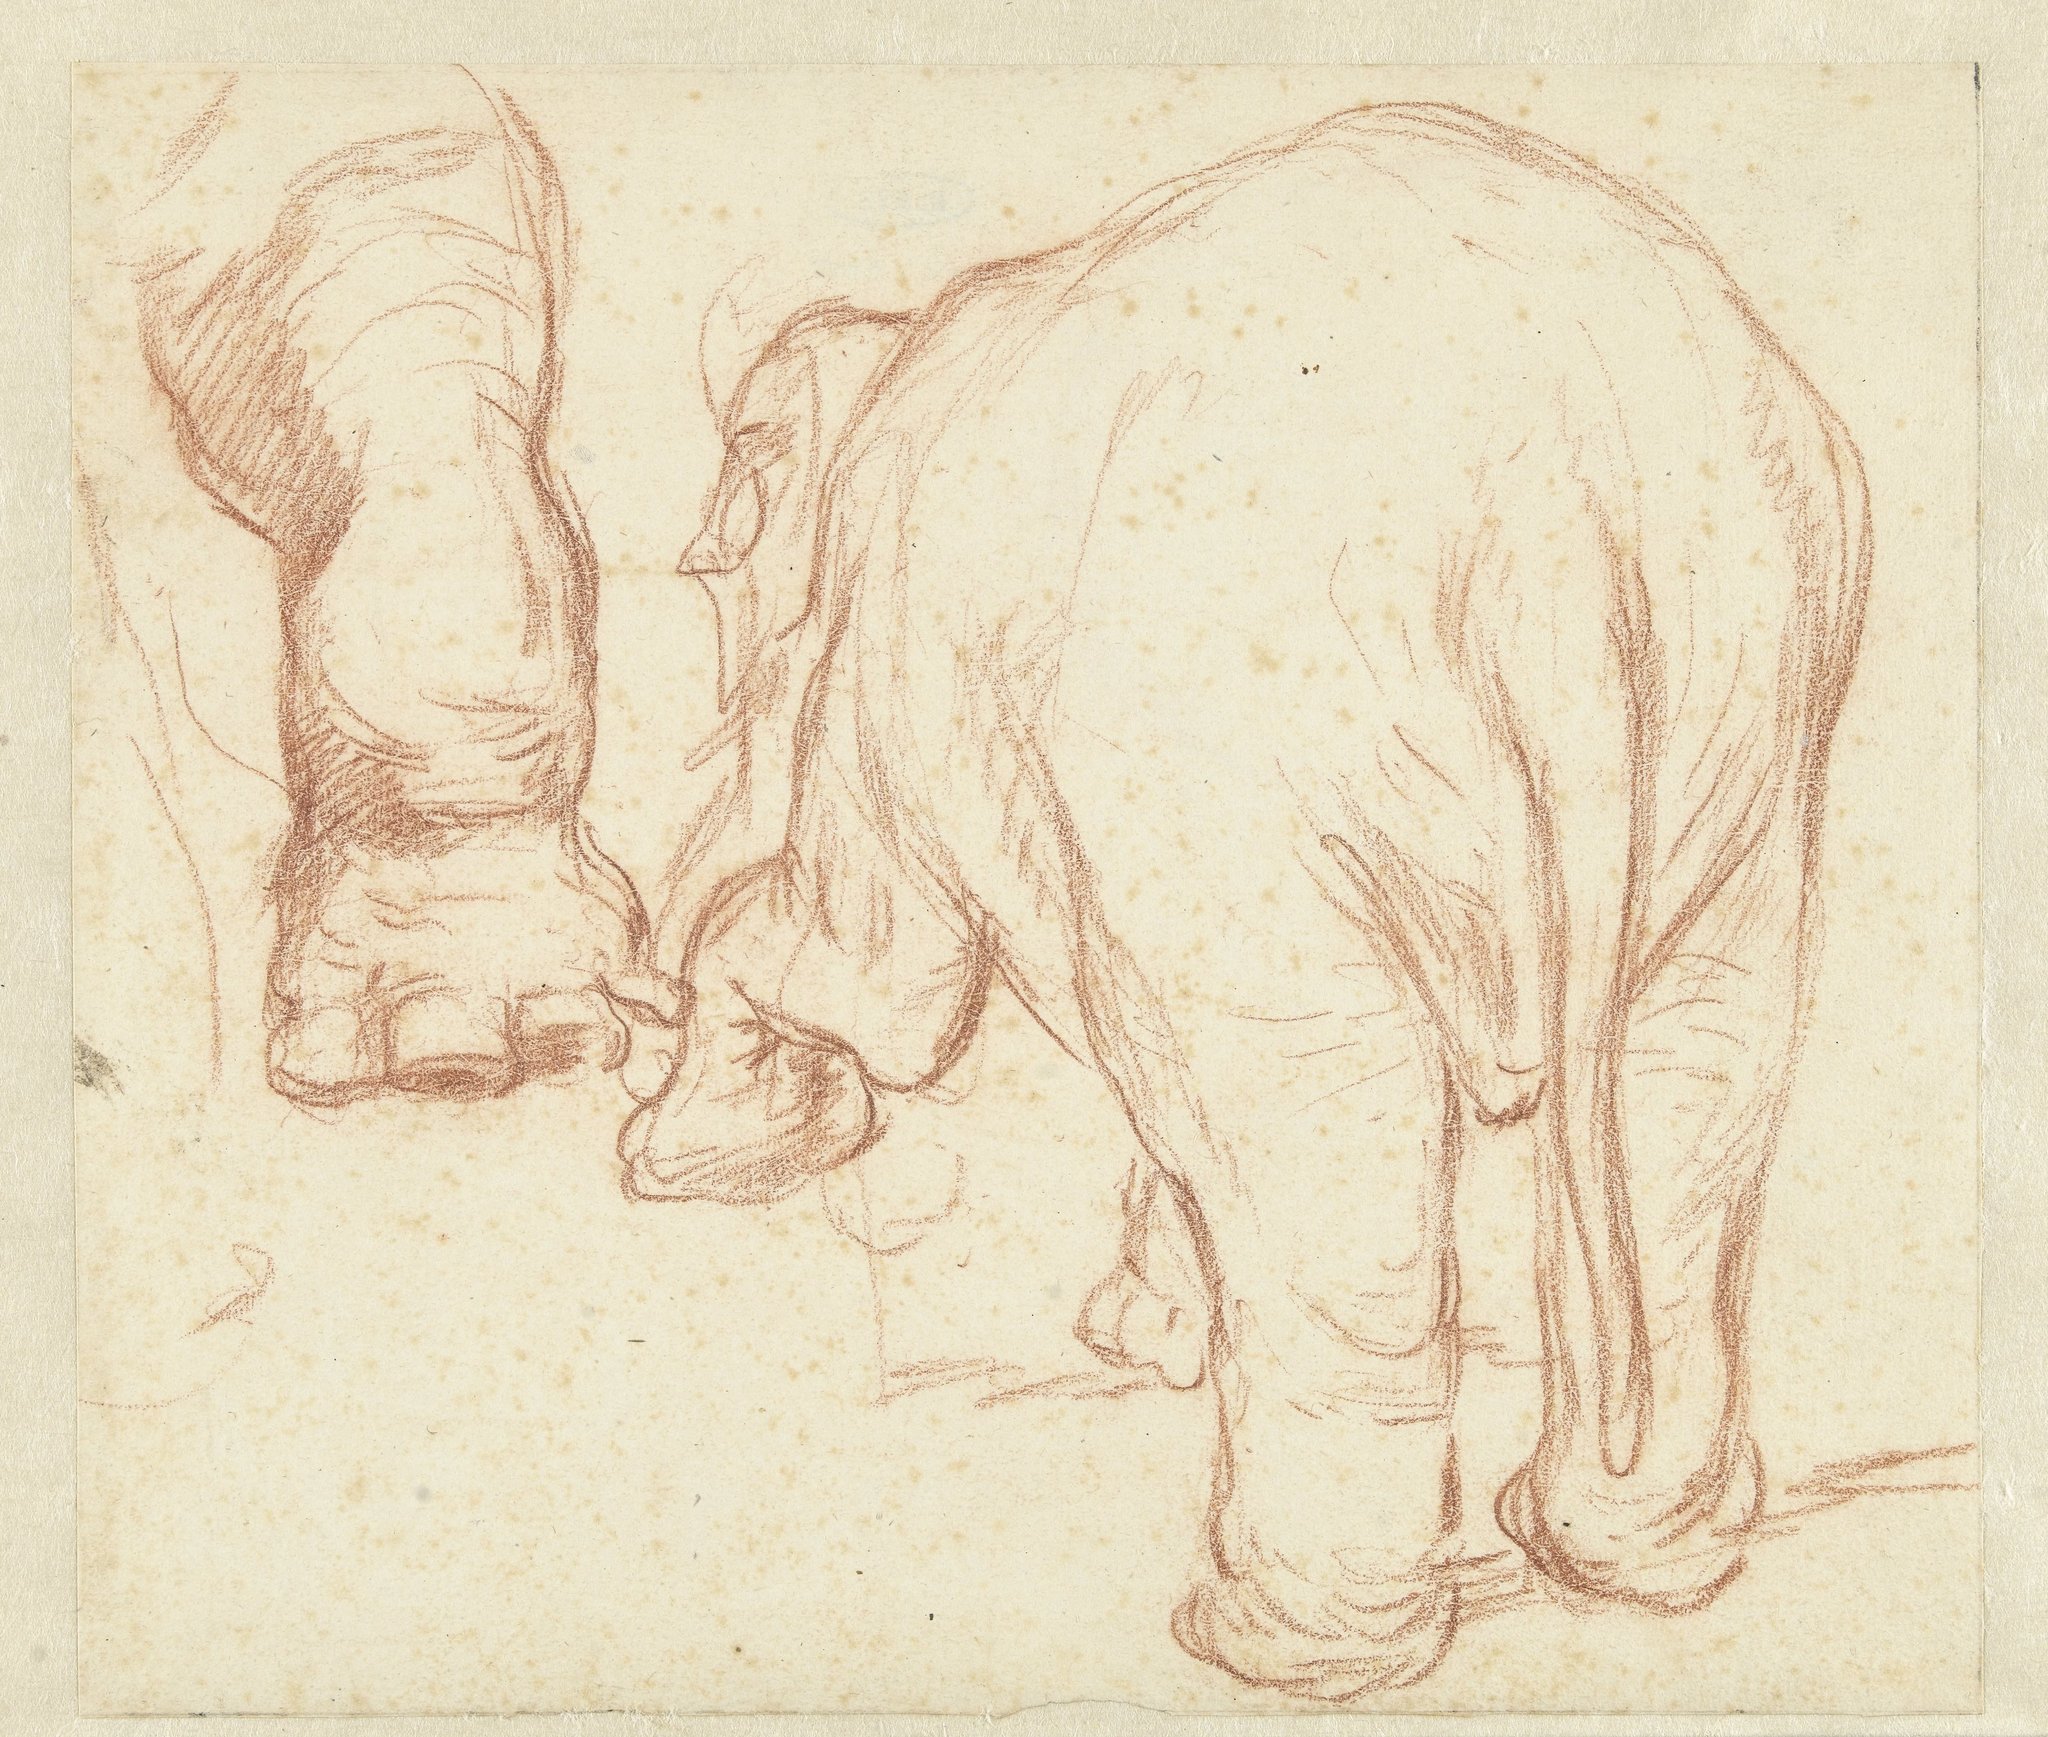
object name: drawing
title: Staande olifant, van achteren, en een poot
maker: petrus camper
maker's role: draughtsman, print maker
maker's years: 1722-1789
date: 1732-1789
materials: chalk, paper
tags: trunked animals: elephant